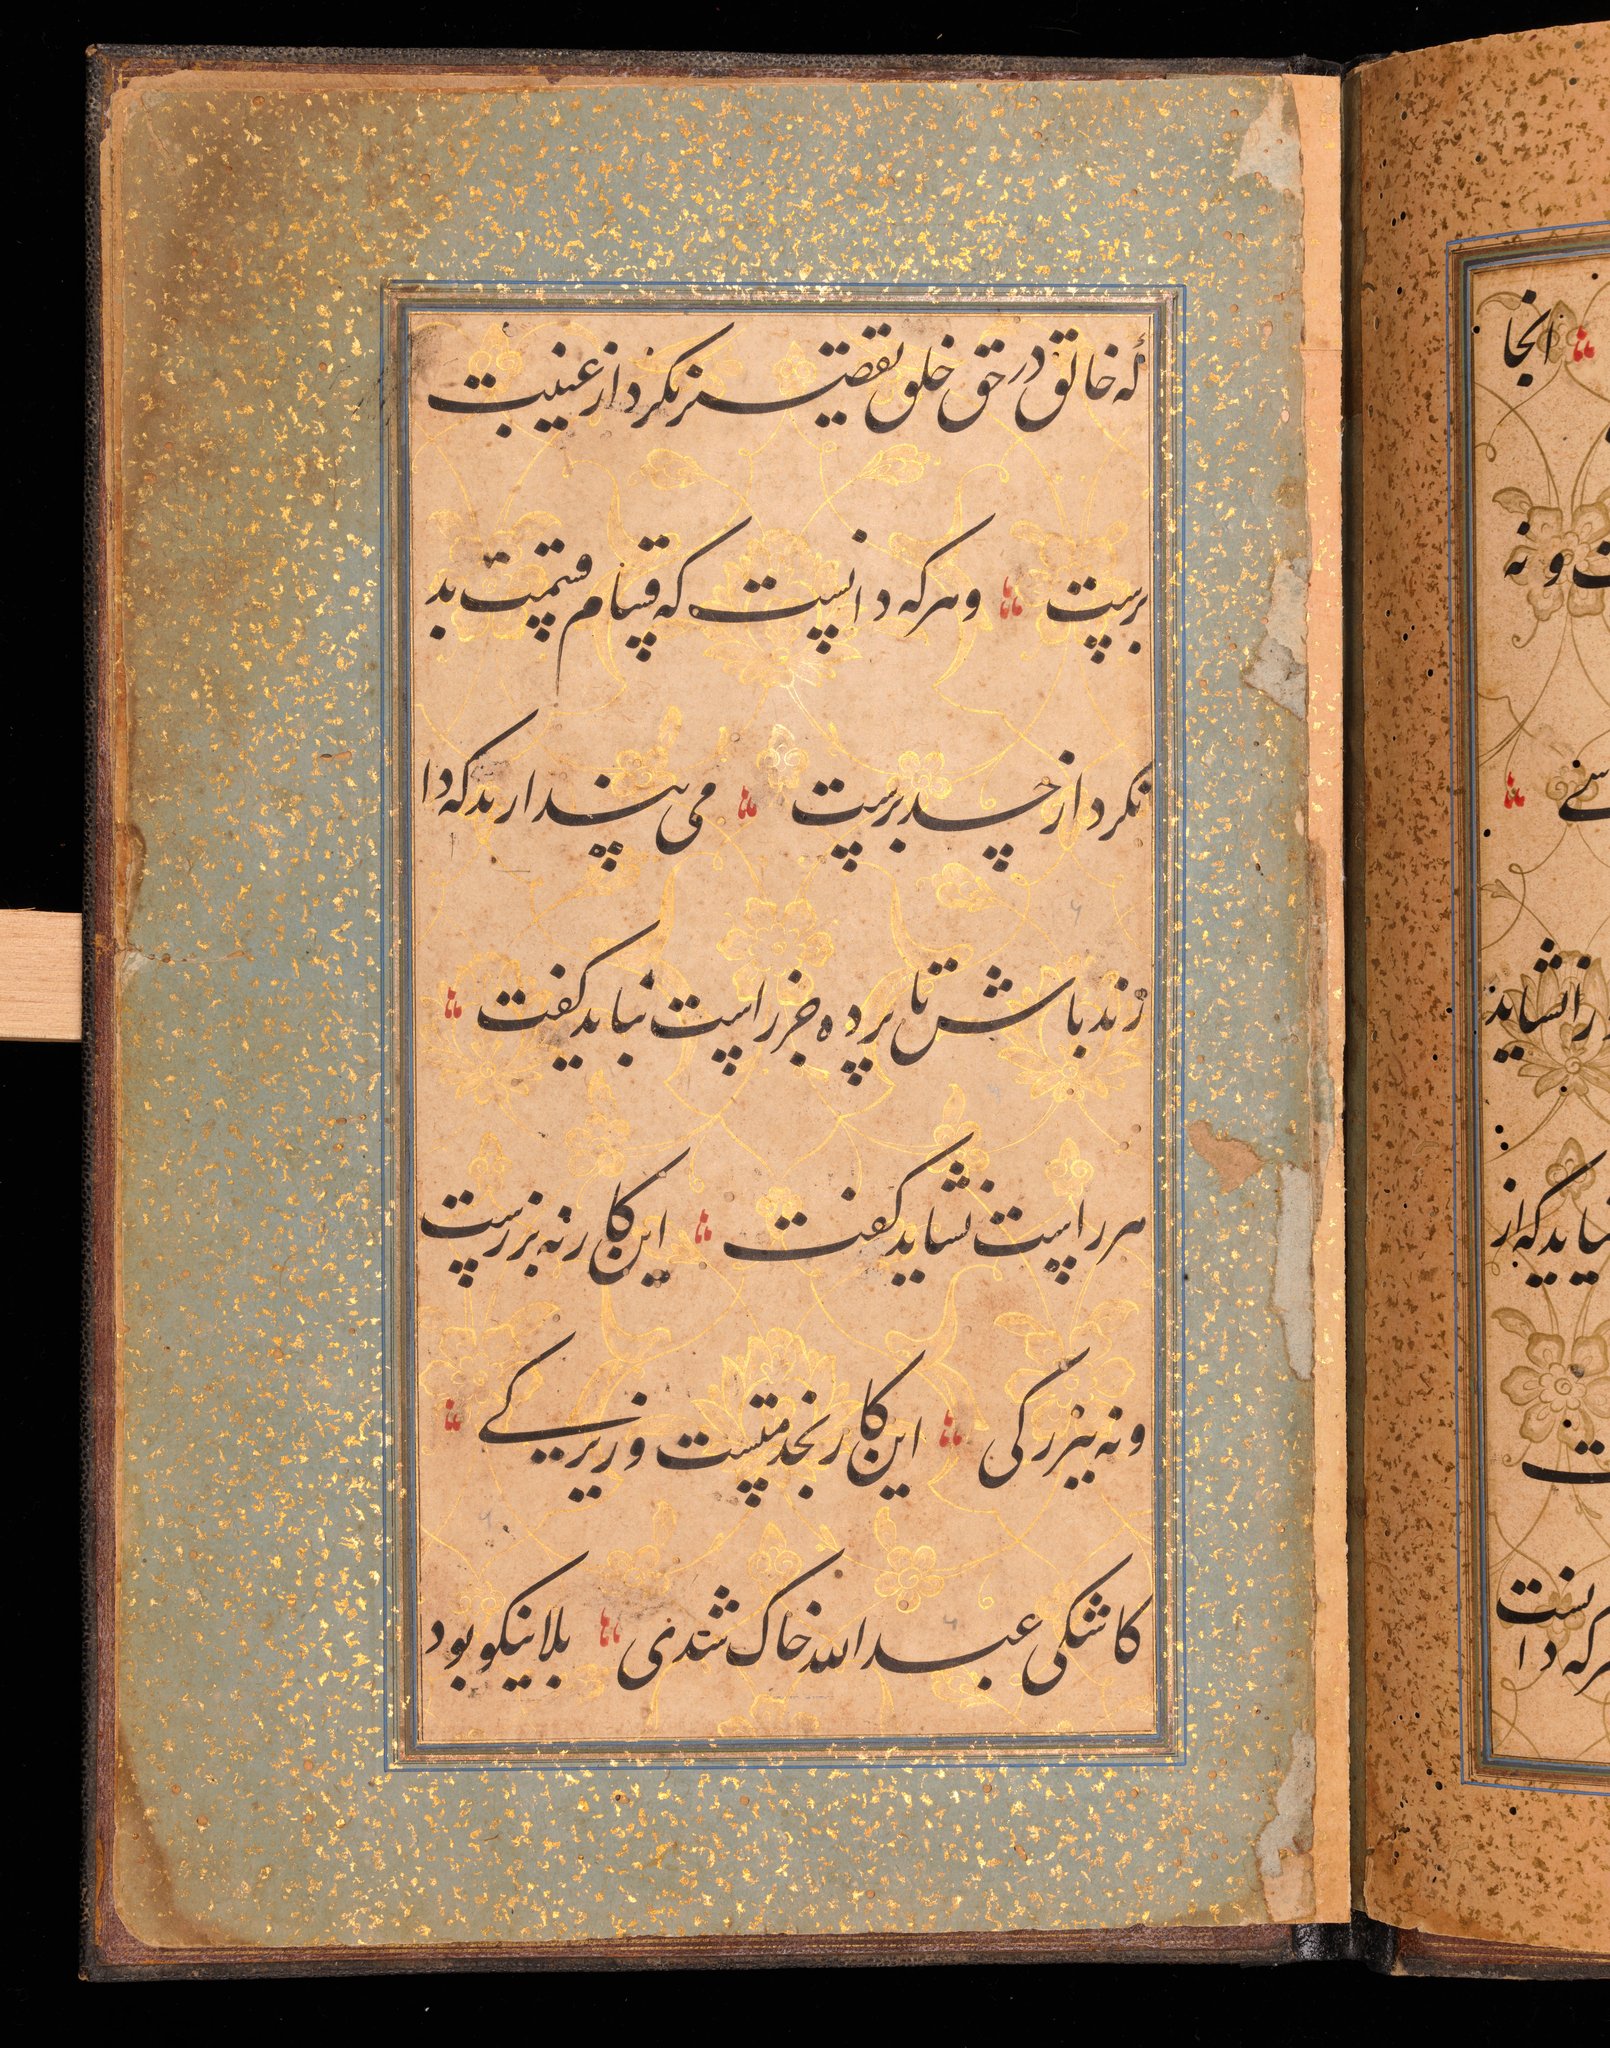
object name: illuminated manuscript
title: Bound Manuscript with Prayers in Praise of Imam 'Ali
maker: hasan 'ali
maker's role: calligrapher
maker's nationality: iranian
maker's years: 1495-1595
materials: gold, ink, leather, paper, watercolor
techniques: bookbinding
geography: iran